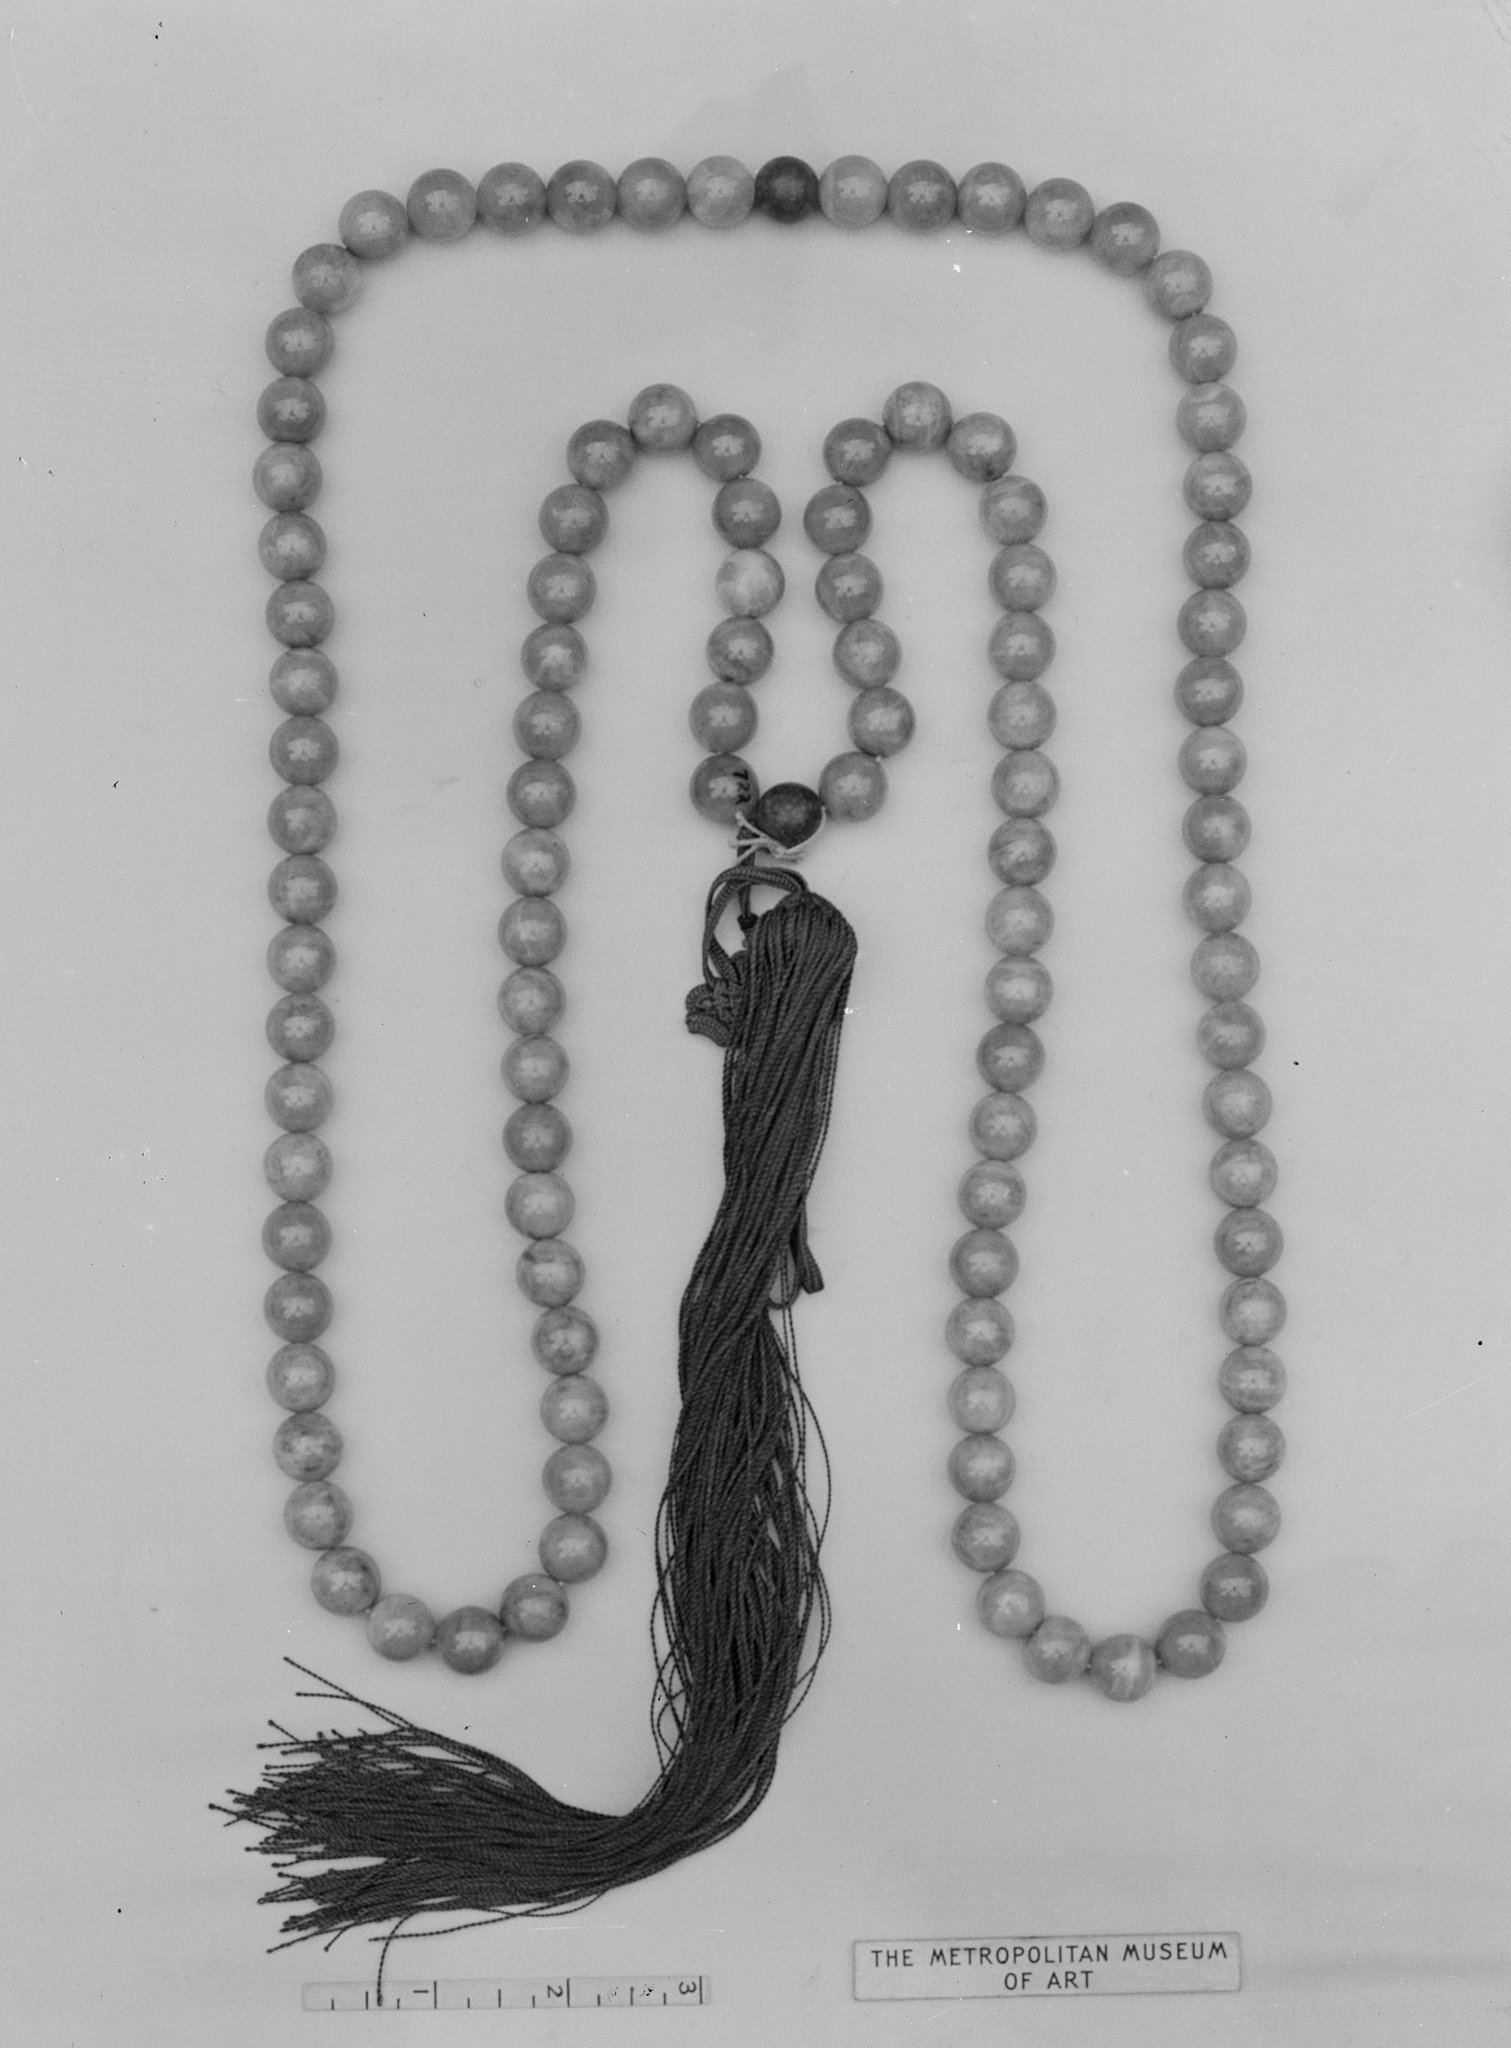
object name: bead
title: Mandarin Beads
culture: chinese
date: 1796-1875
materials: jade